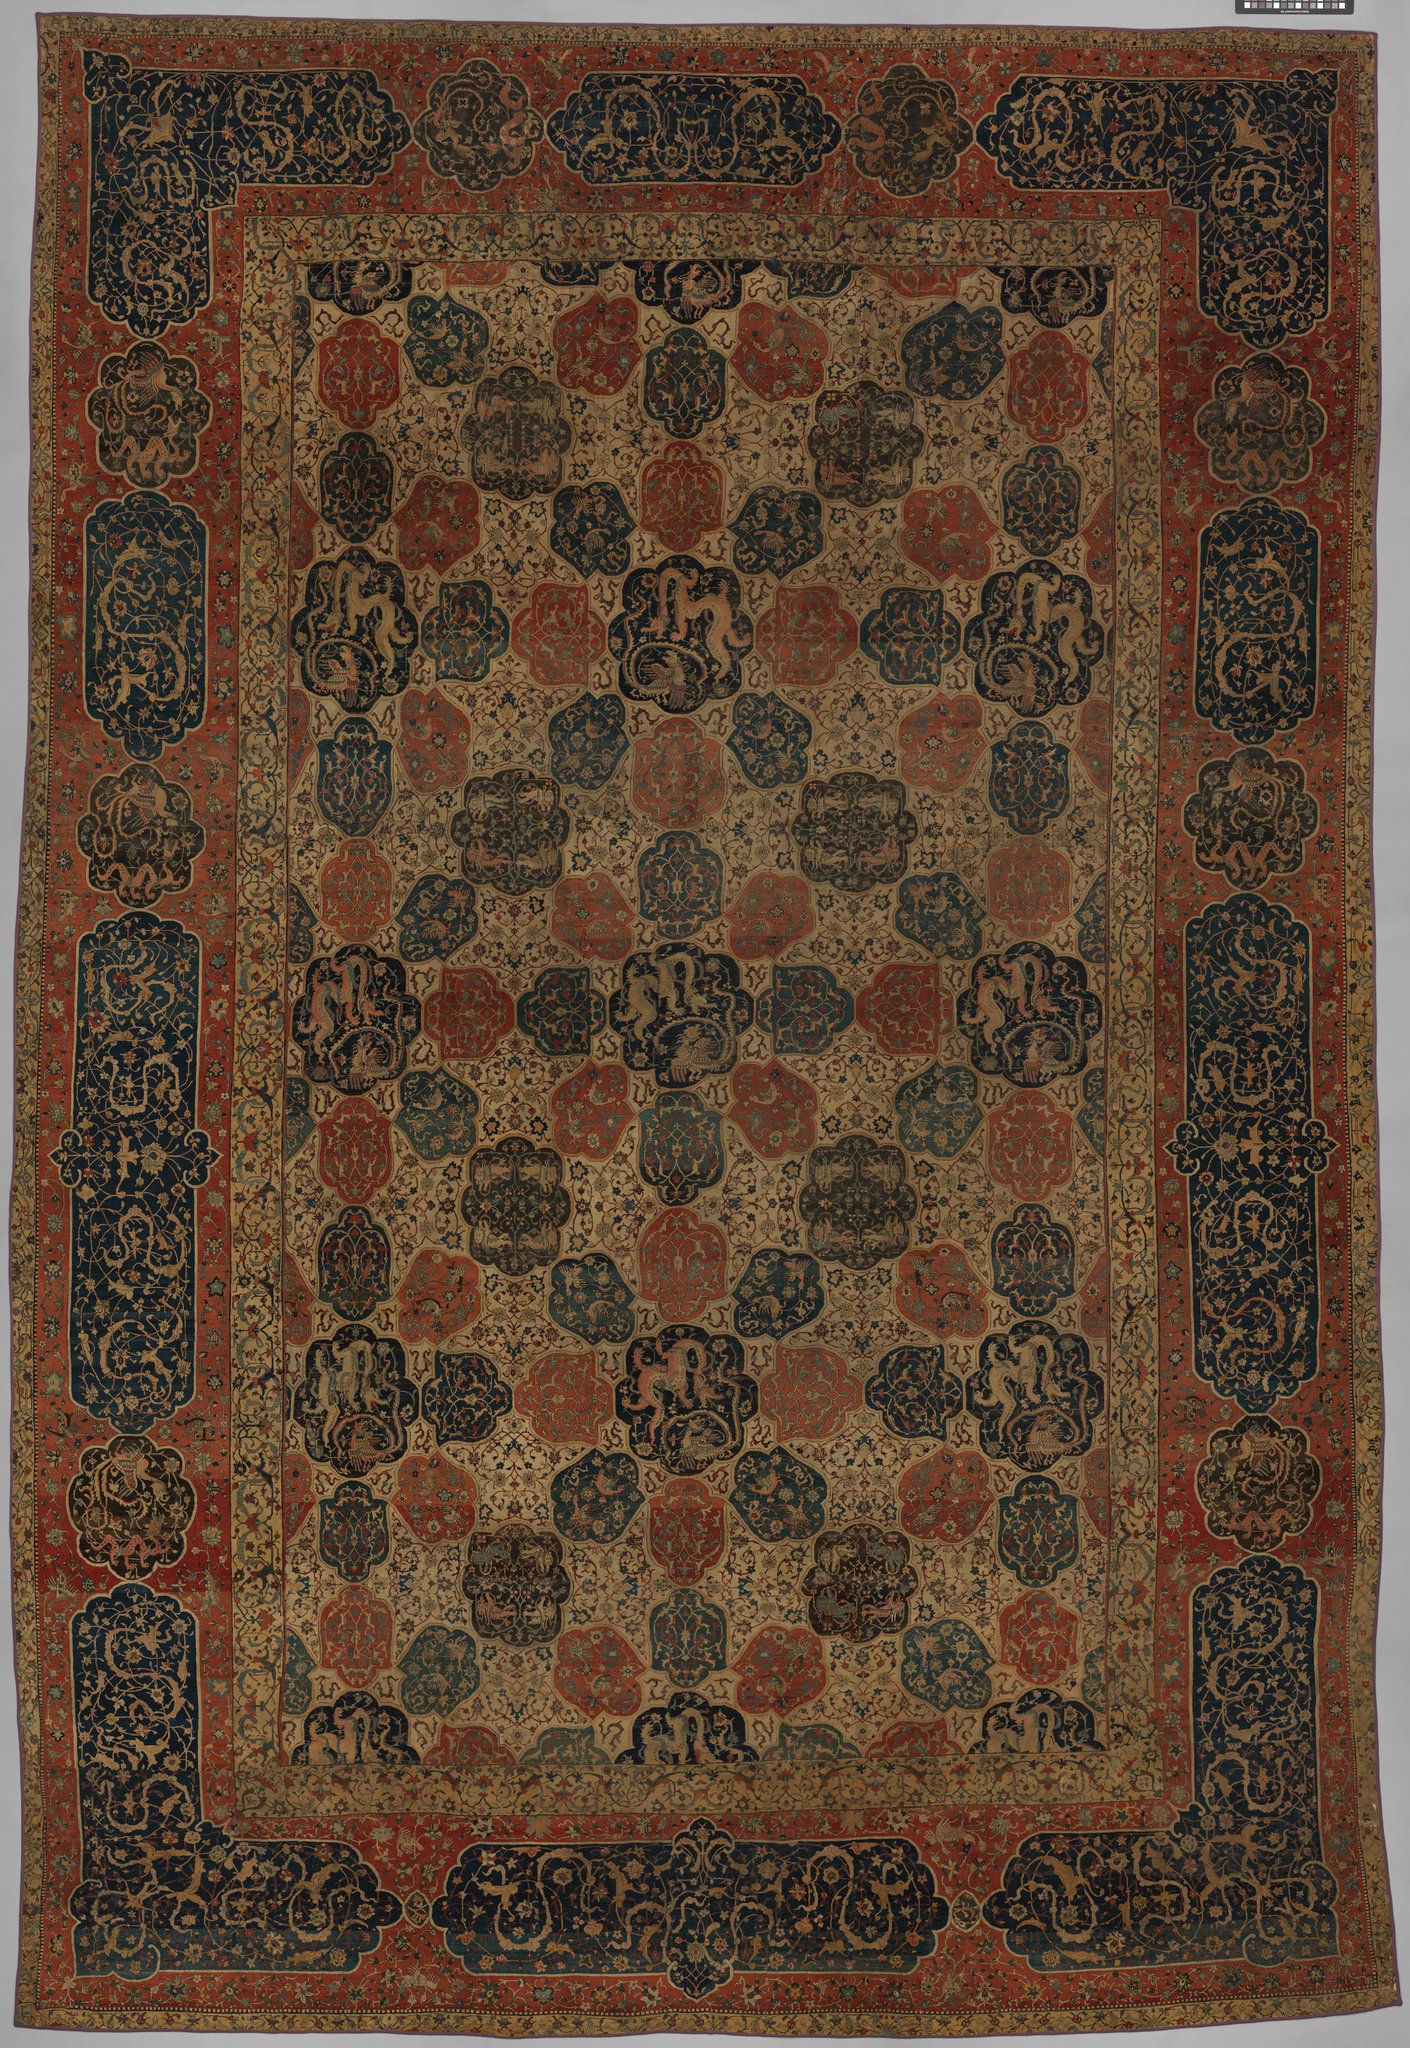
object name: carpet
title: Carpet with a Compartment Design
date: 1501-1550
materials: silk, wool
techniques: asymmetrically knotted pile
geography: iran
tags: ducks,dragons,phoenix